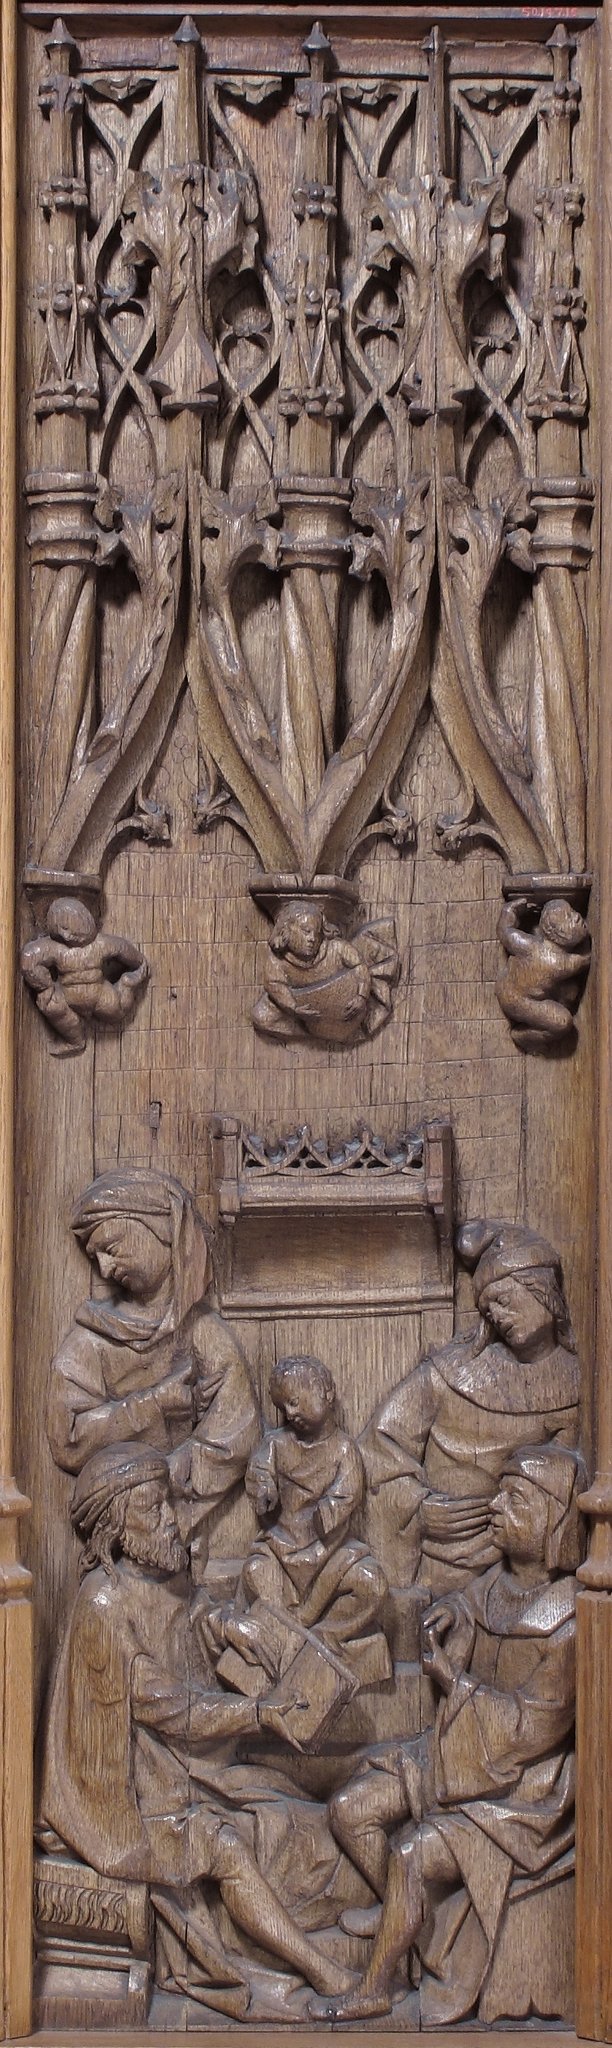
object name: panel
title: Panel with Christ Among the Doctors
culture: french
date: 1501-1533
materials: wood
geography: france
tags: human figures,men,christ,doctors